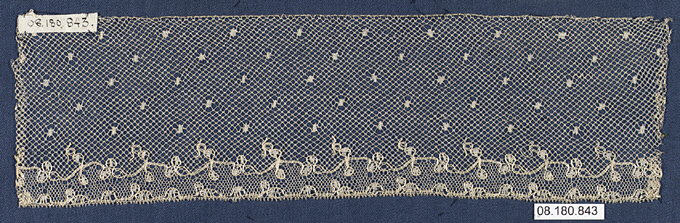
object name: piece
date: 1801-1900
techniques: lace